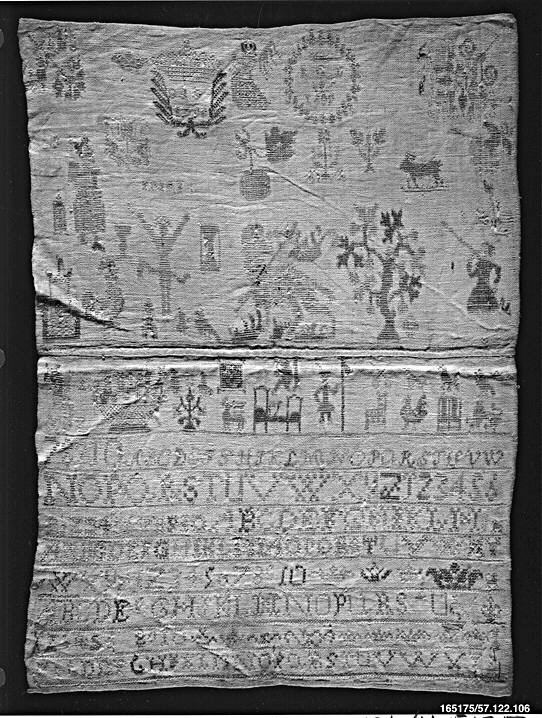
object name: sampler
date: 1799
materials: linen, silk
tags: human figures,trees